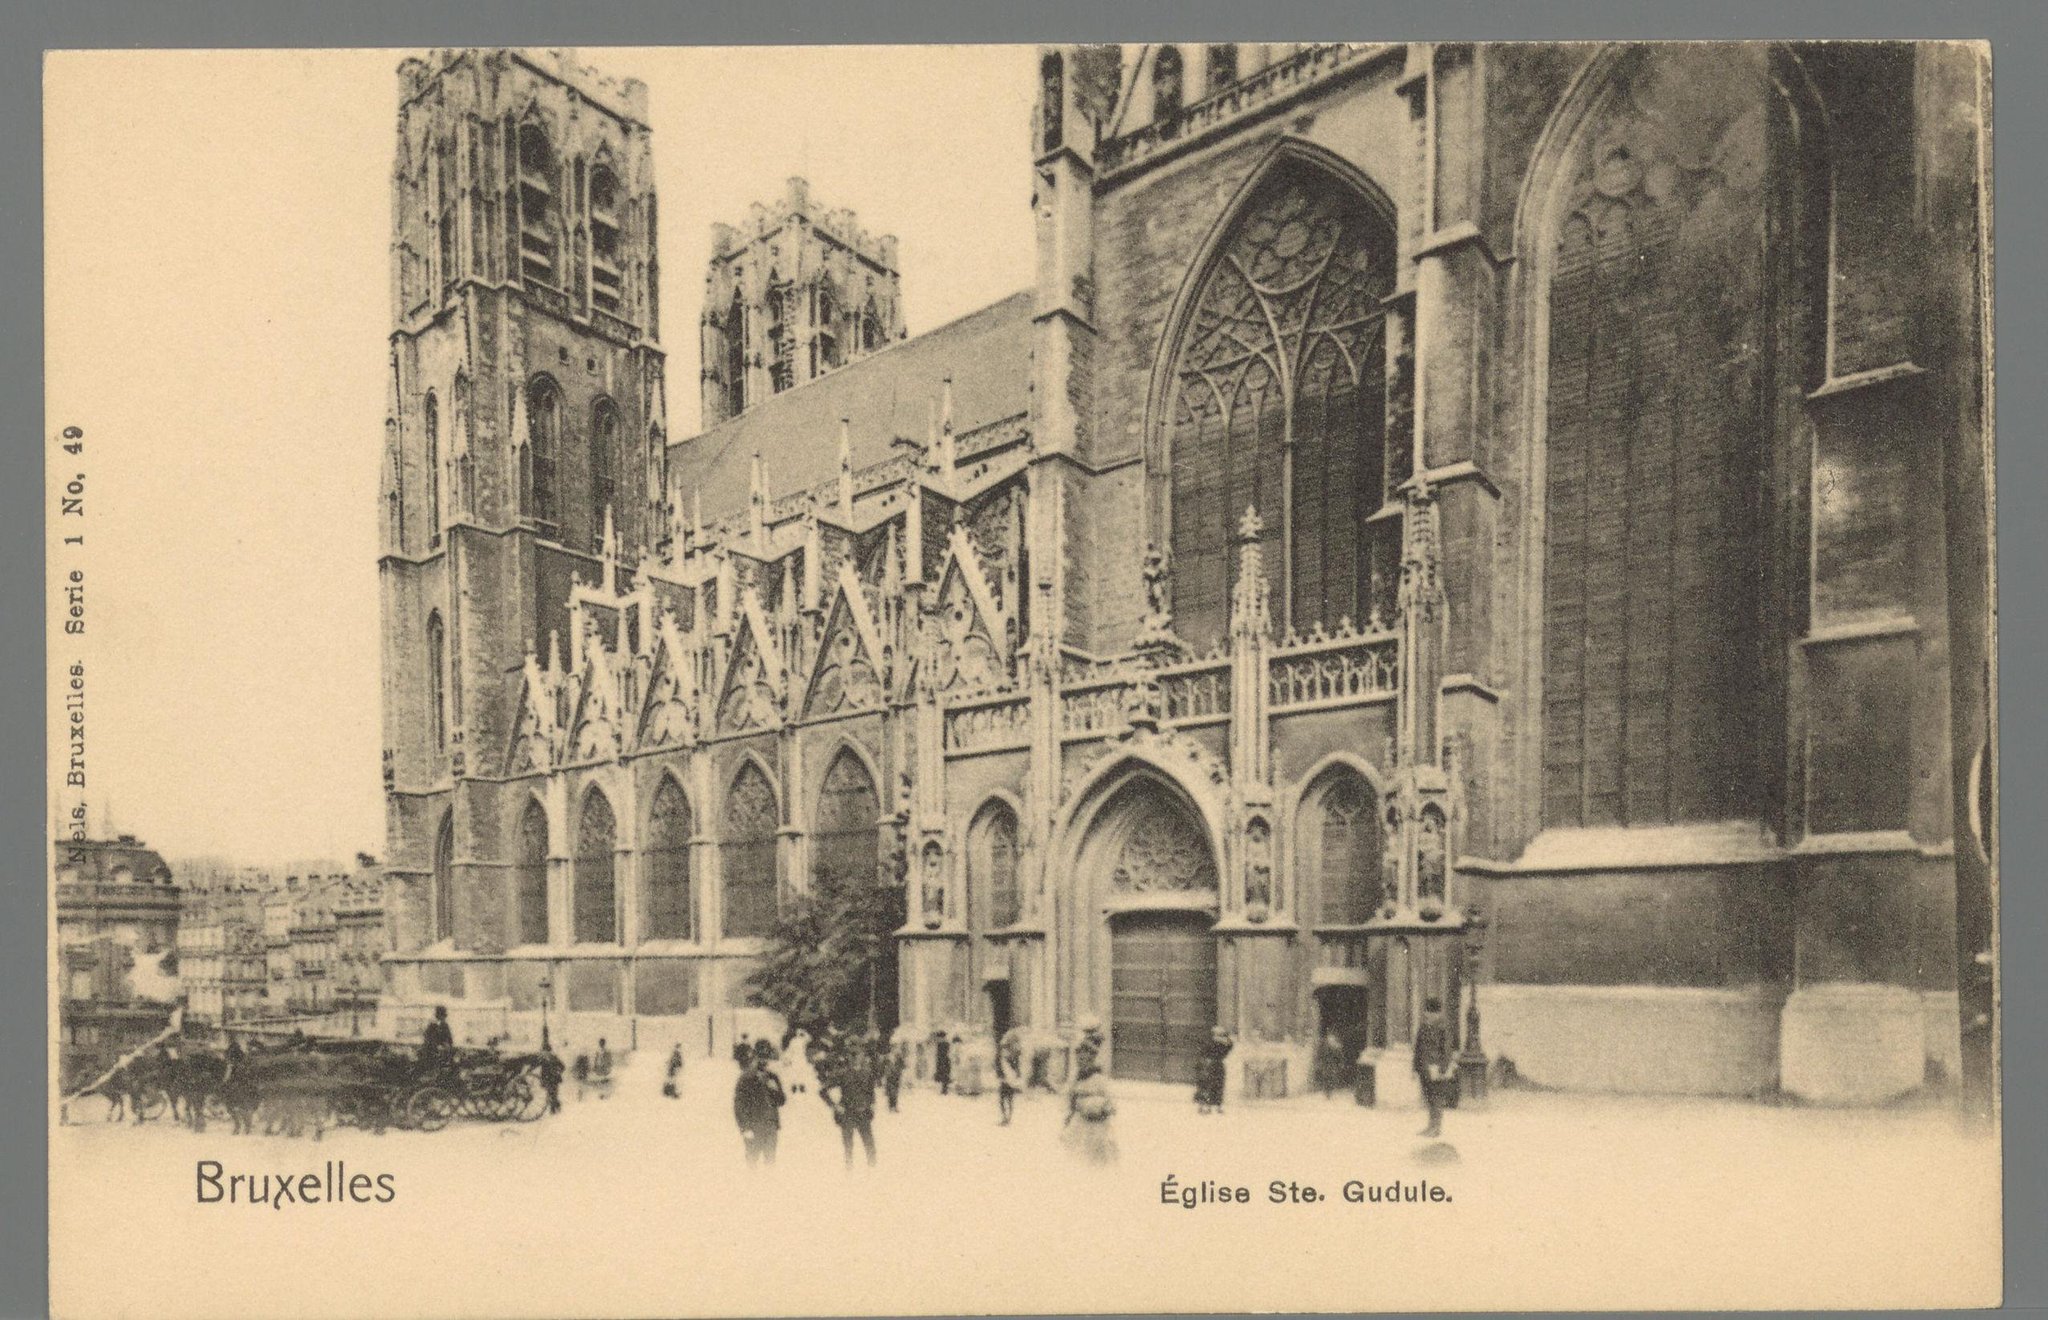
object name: photomechanical print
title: Serie 1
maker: Anonymous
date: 1898-1906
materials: cardboard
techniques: photograph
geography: brussels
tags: church (exterior), city-view, and landscape with man-made constructions (+ city(-scape) with figures, staffage)